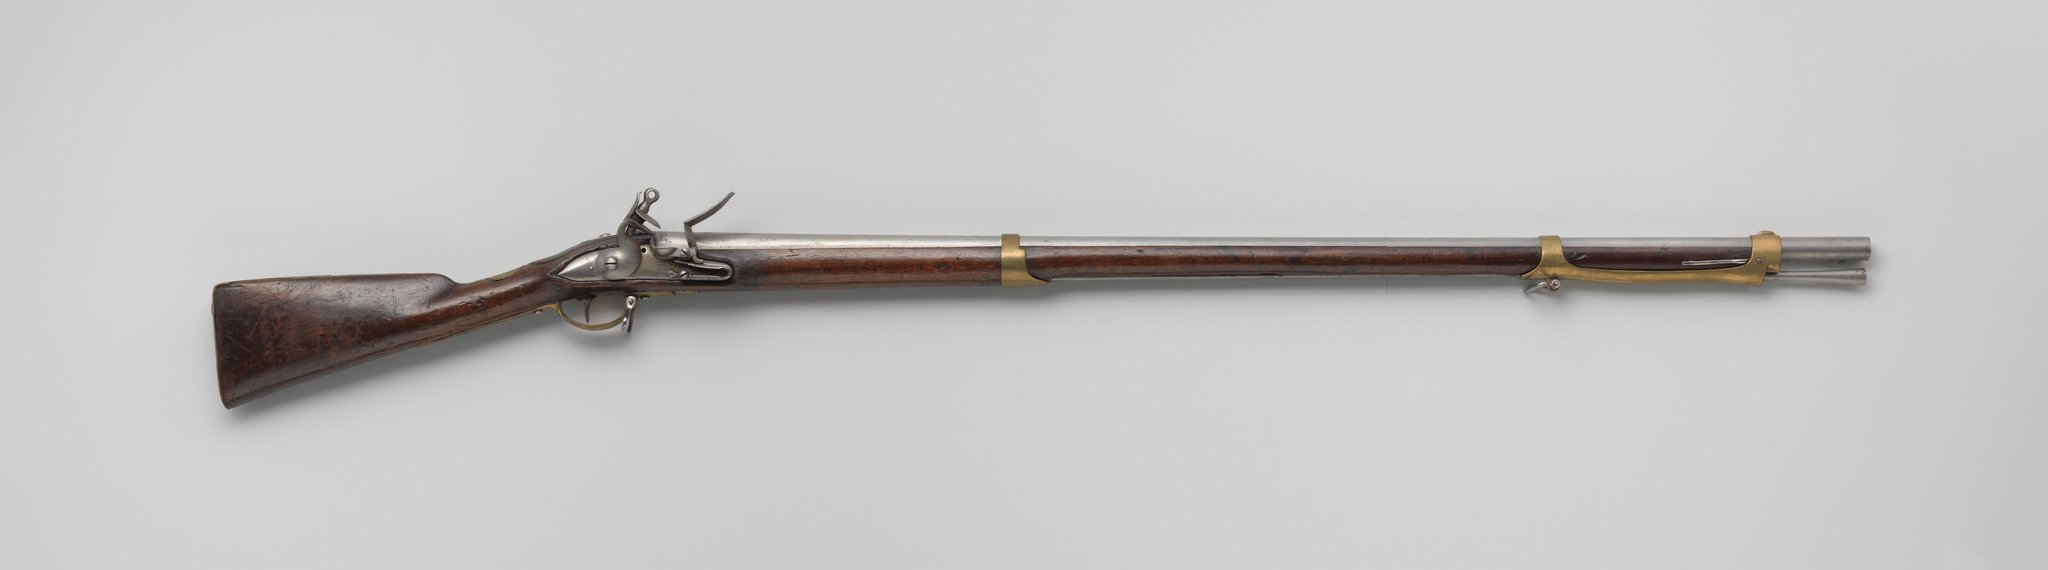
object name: flintlock pistol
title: Vuursteengeweer Amsterdamse Schutterij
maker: Anonymous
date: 1782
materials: brass, steel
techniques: printing, engraving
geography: amsterdam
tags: amsterdam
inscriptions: mark, mark, inscription: ‘1782 // W.K. 31 // N=89’